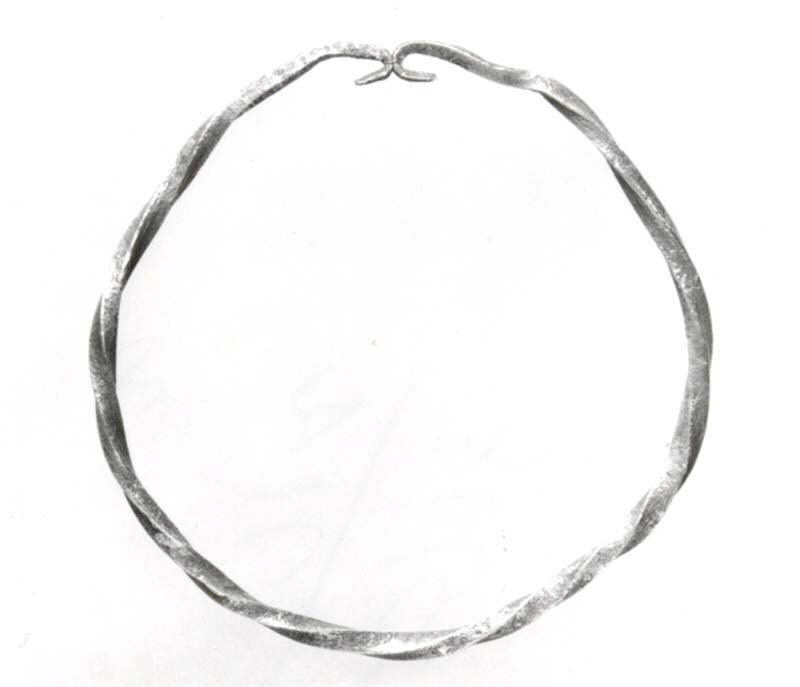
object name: bracelet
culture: iranian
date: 1-1000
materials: silver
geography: iran